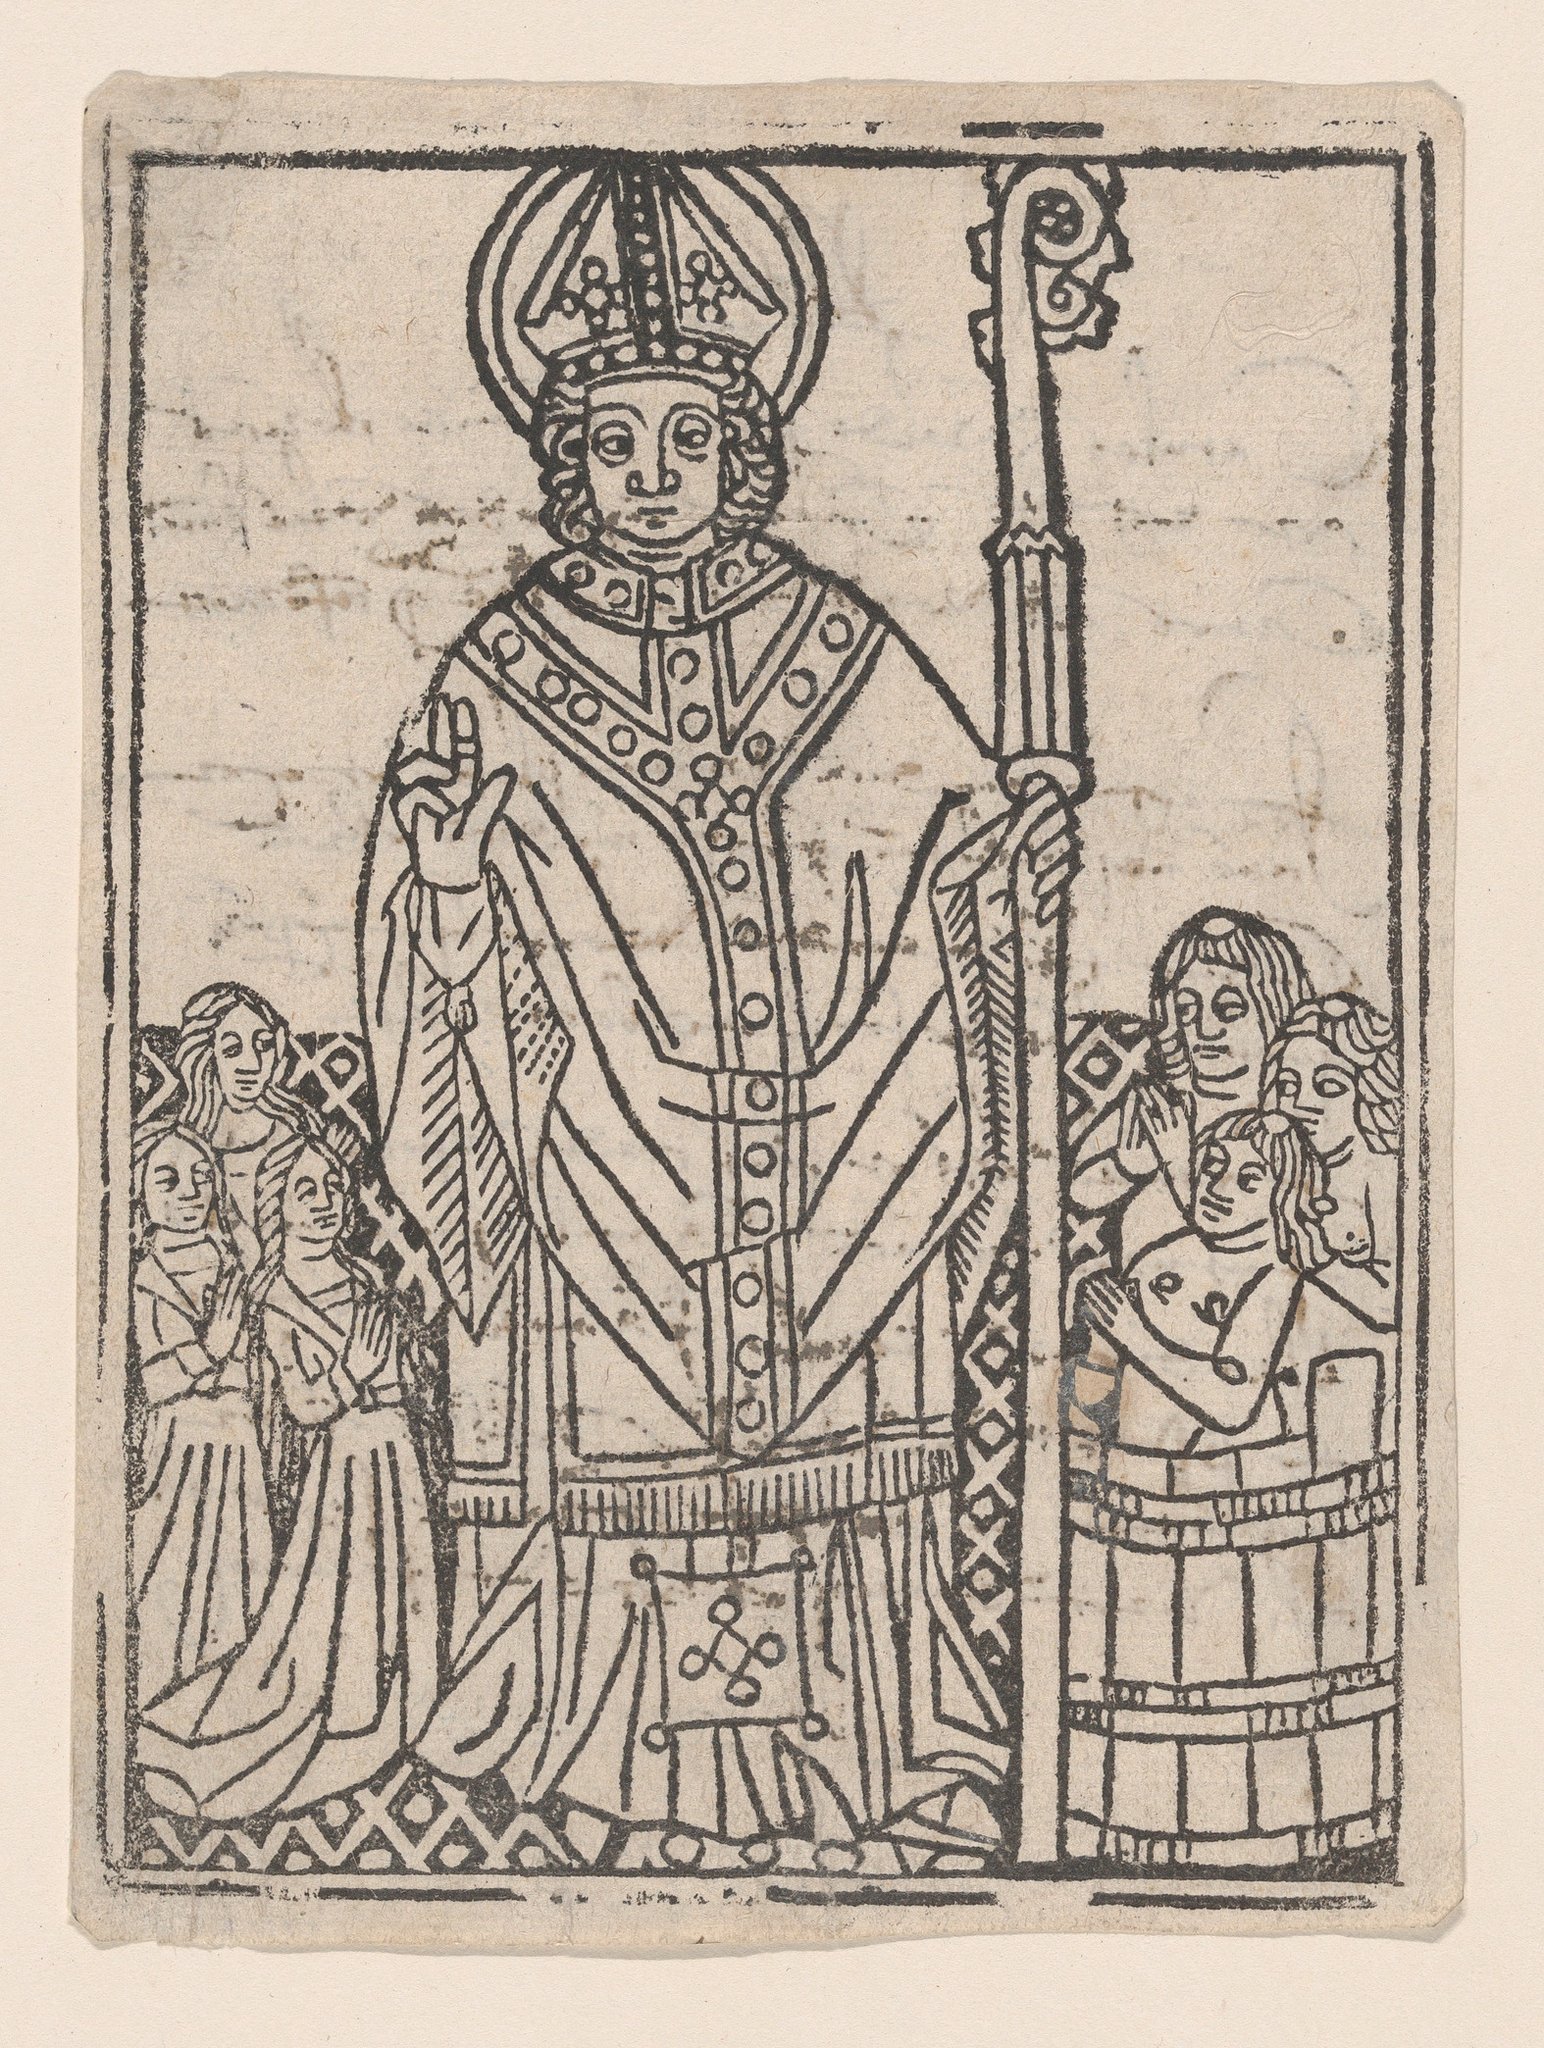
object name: print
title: Saint Nicholas of Myra flanked by praying figures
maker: anonymous, italian, 15th century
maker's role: artist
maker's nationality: italian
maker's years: 1400-1500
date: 1460-1470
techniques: woodcut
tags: men,women,croziers,saints